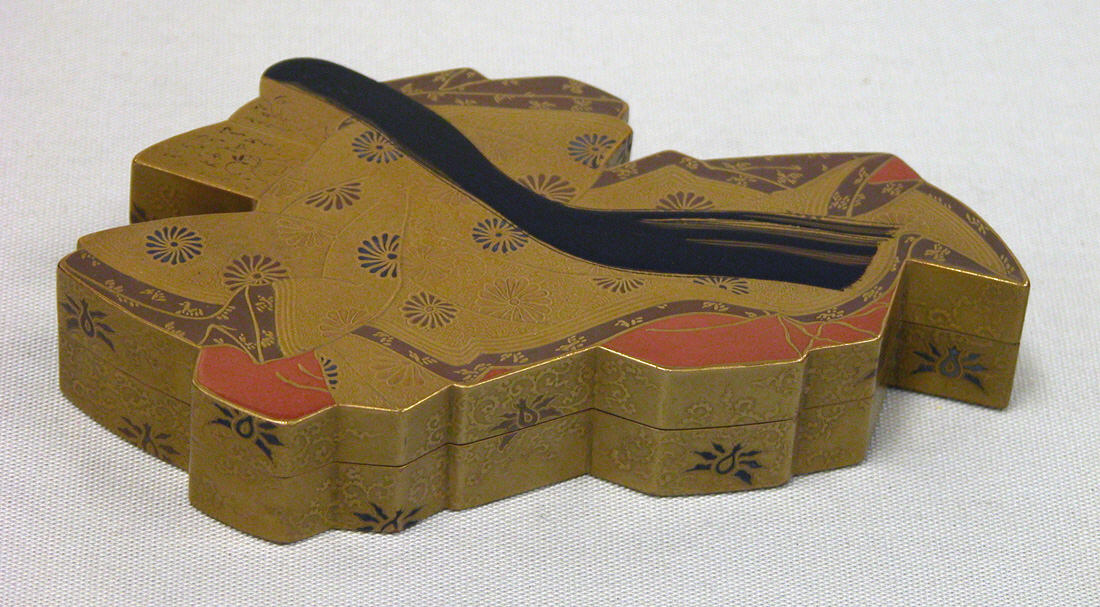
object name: box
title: Box in the Shape of a Court Lady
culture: japanese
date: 1701-1800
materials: gold, lacquer, wood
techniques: lacquer, maki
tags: women